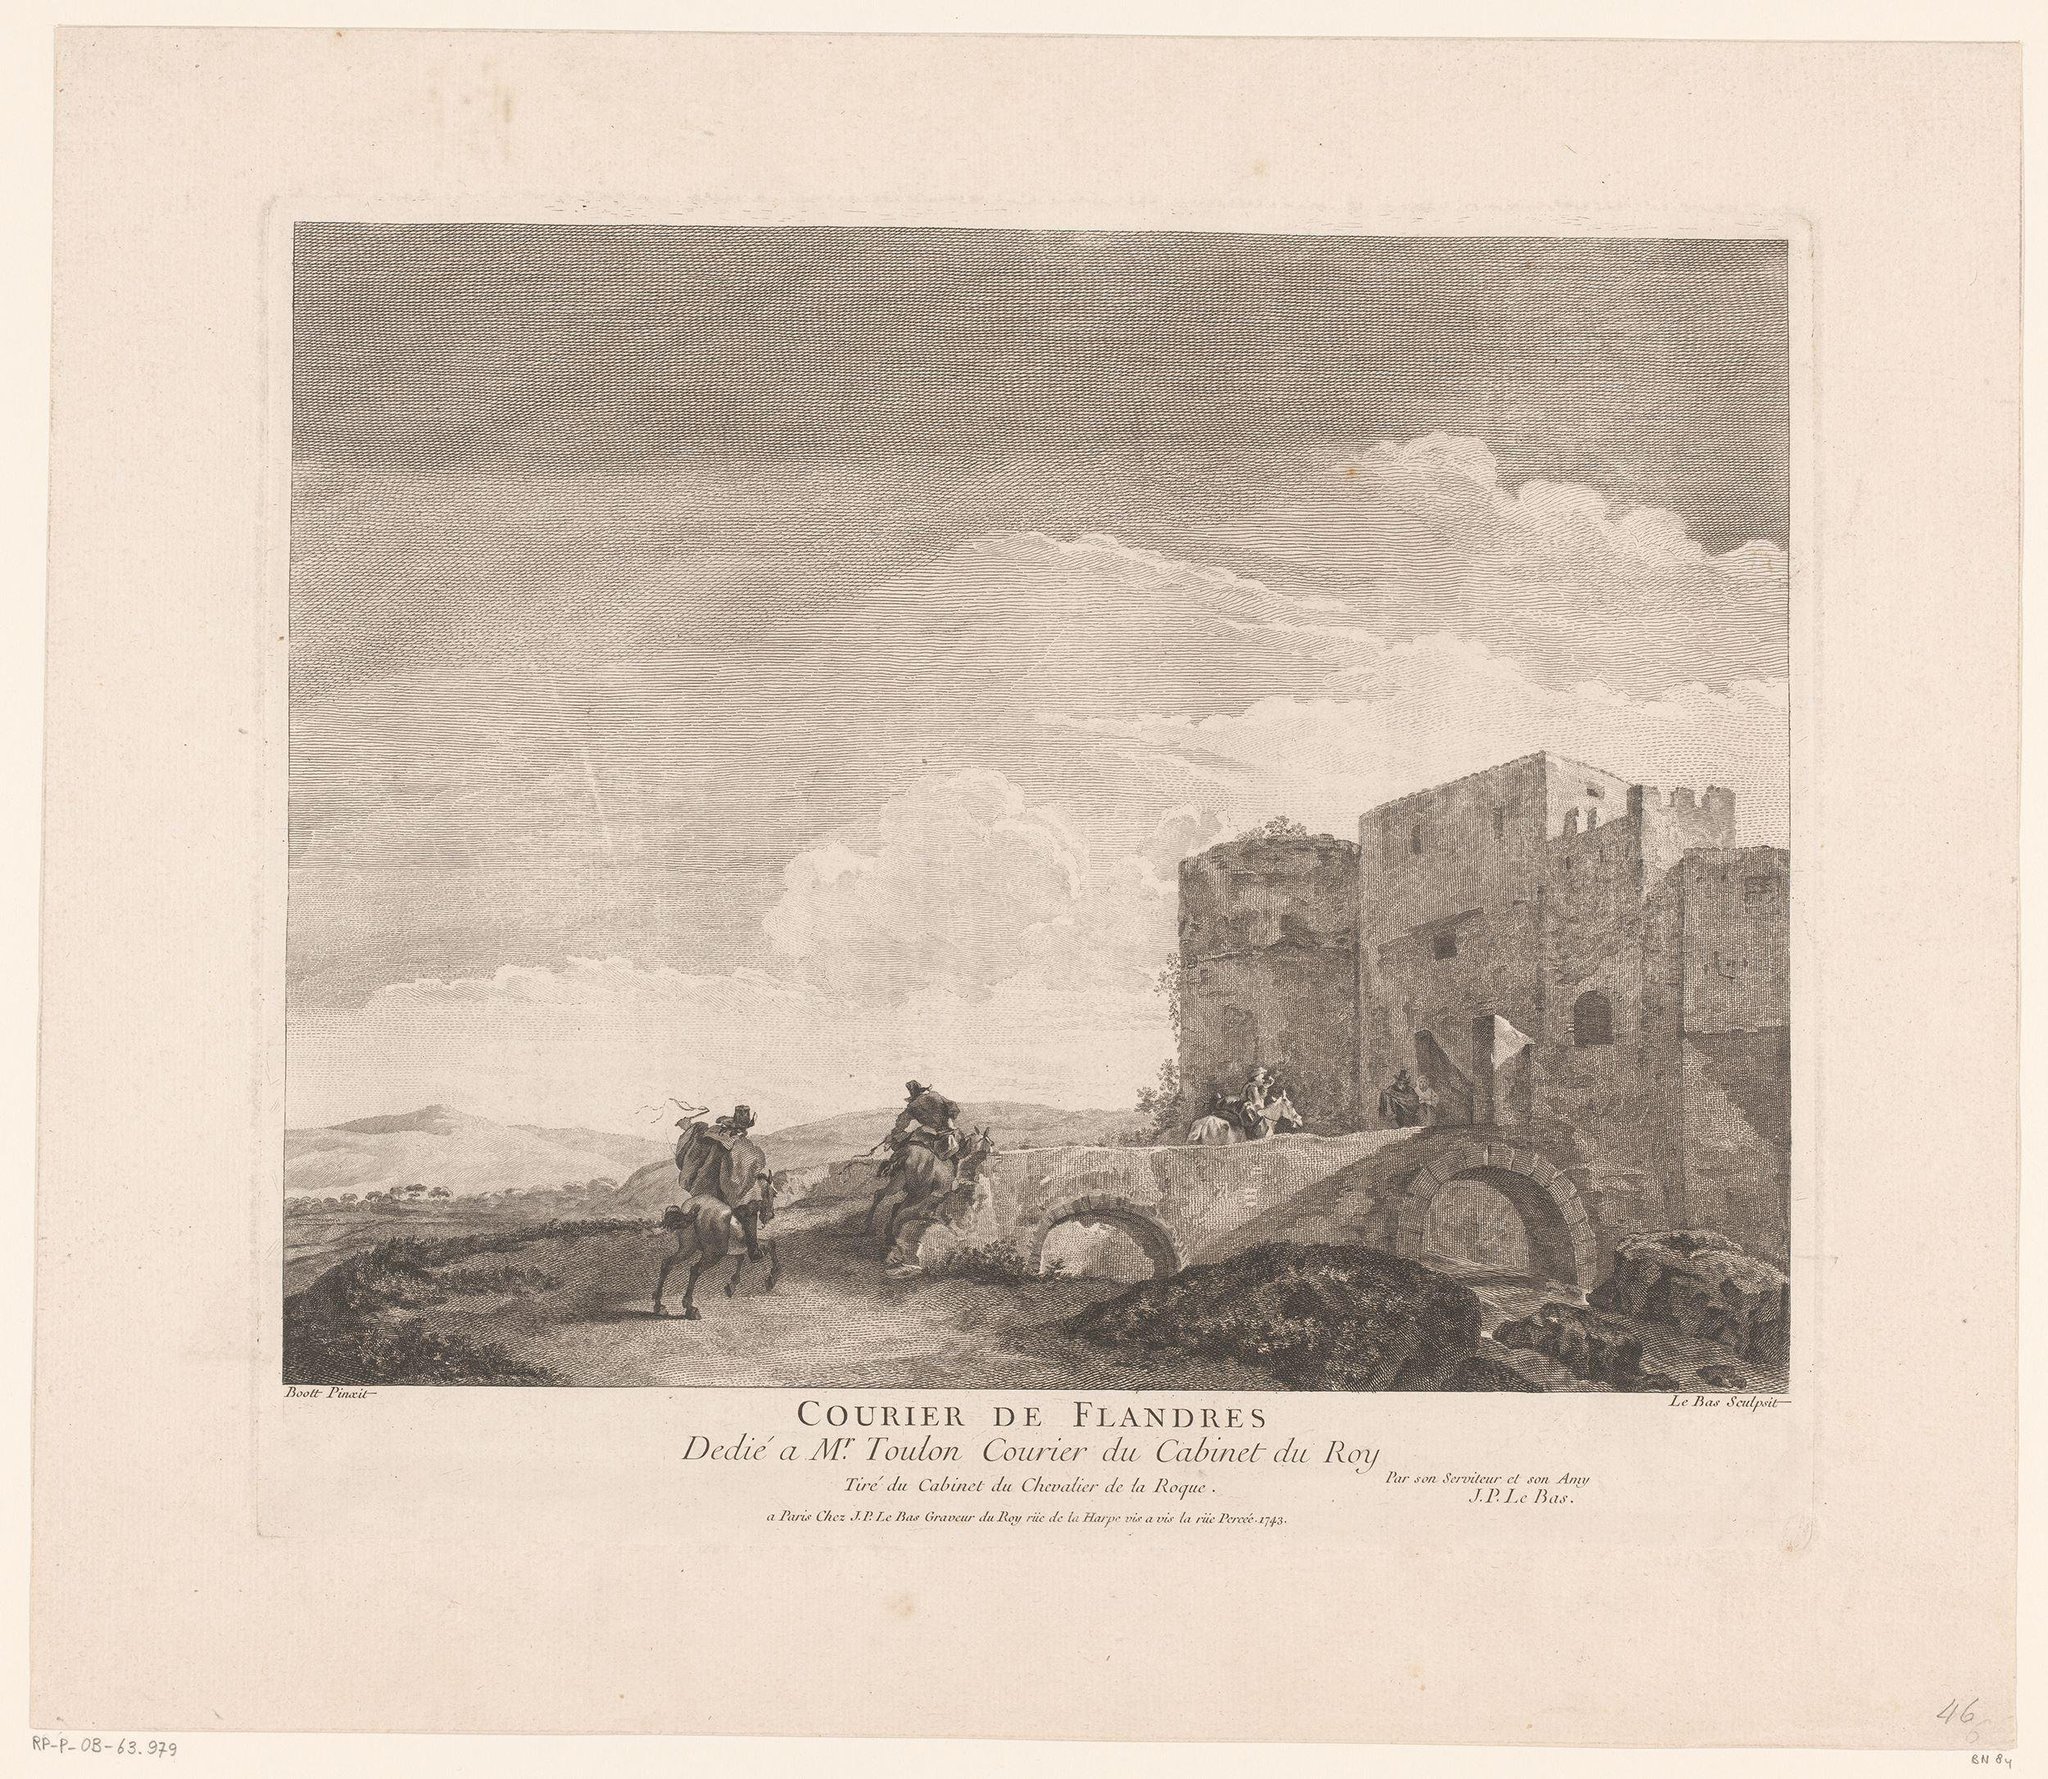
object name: print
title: Landschap met ruiters bij een brug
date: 1743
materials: paper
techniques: etching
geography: paris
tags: riding a horse, ass, or mule; rider, horseman, landscape with bridge, viaduct or aqueduct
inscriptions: collector's mark: Lugt 240